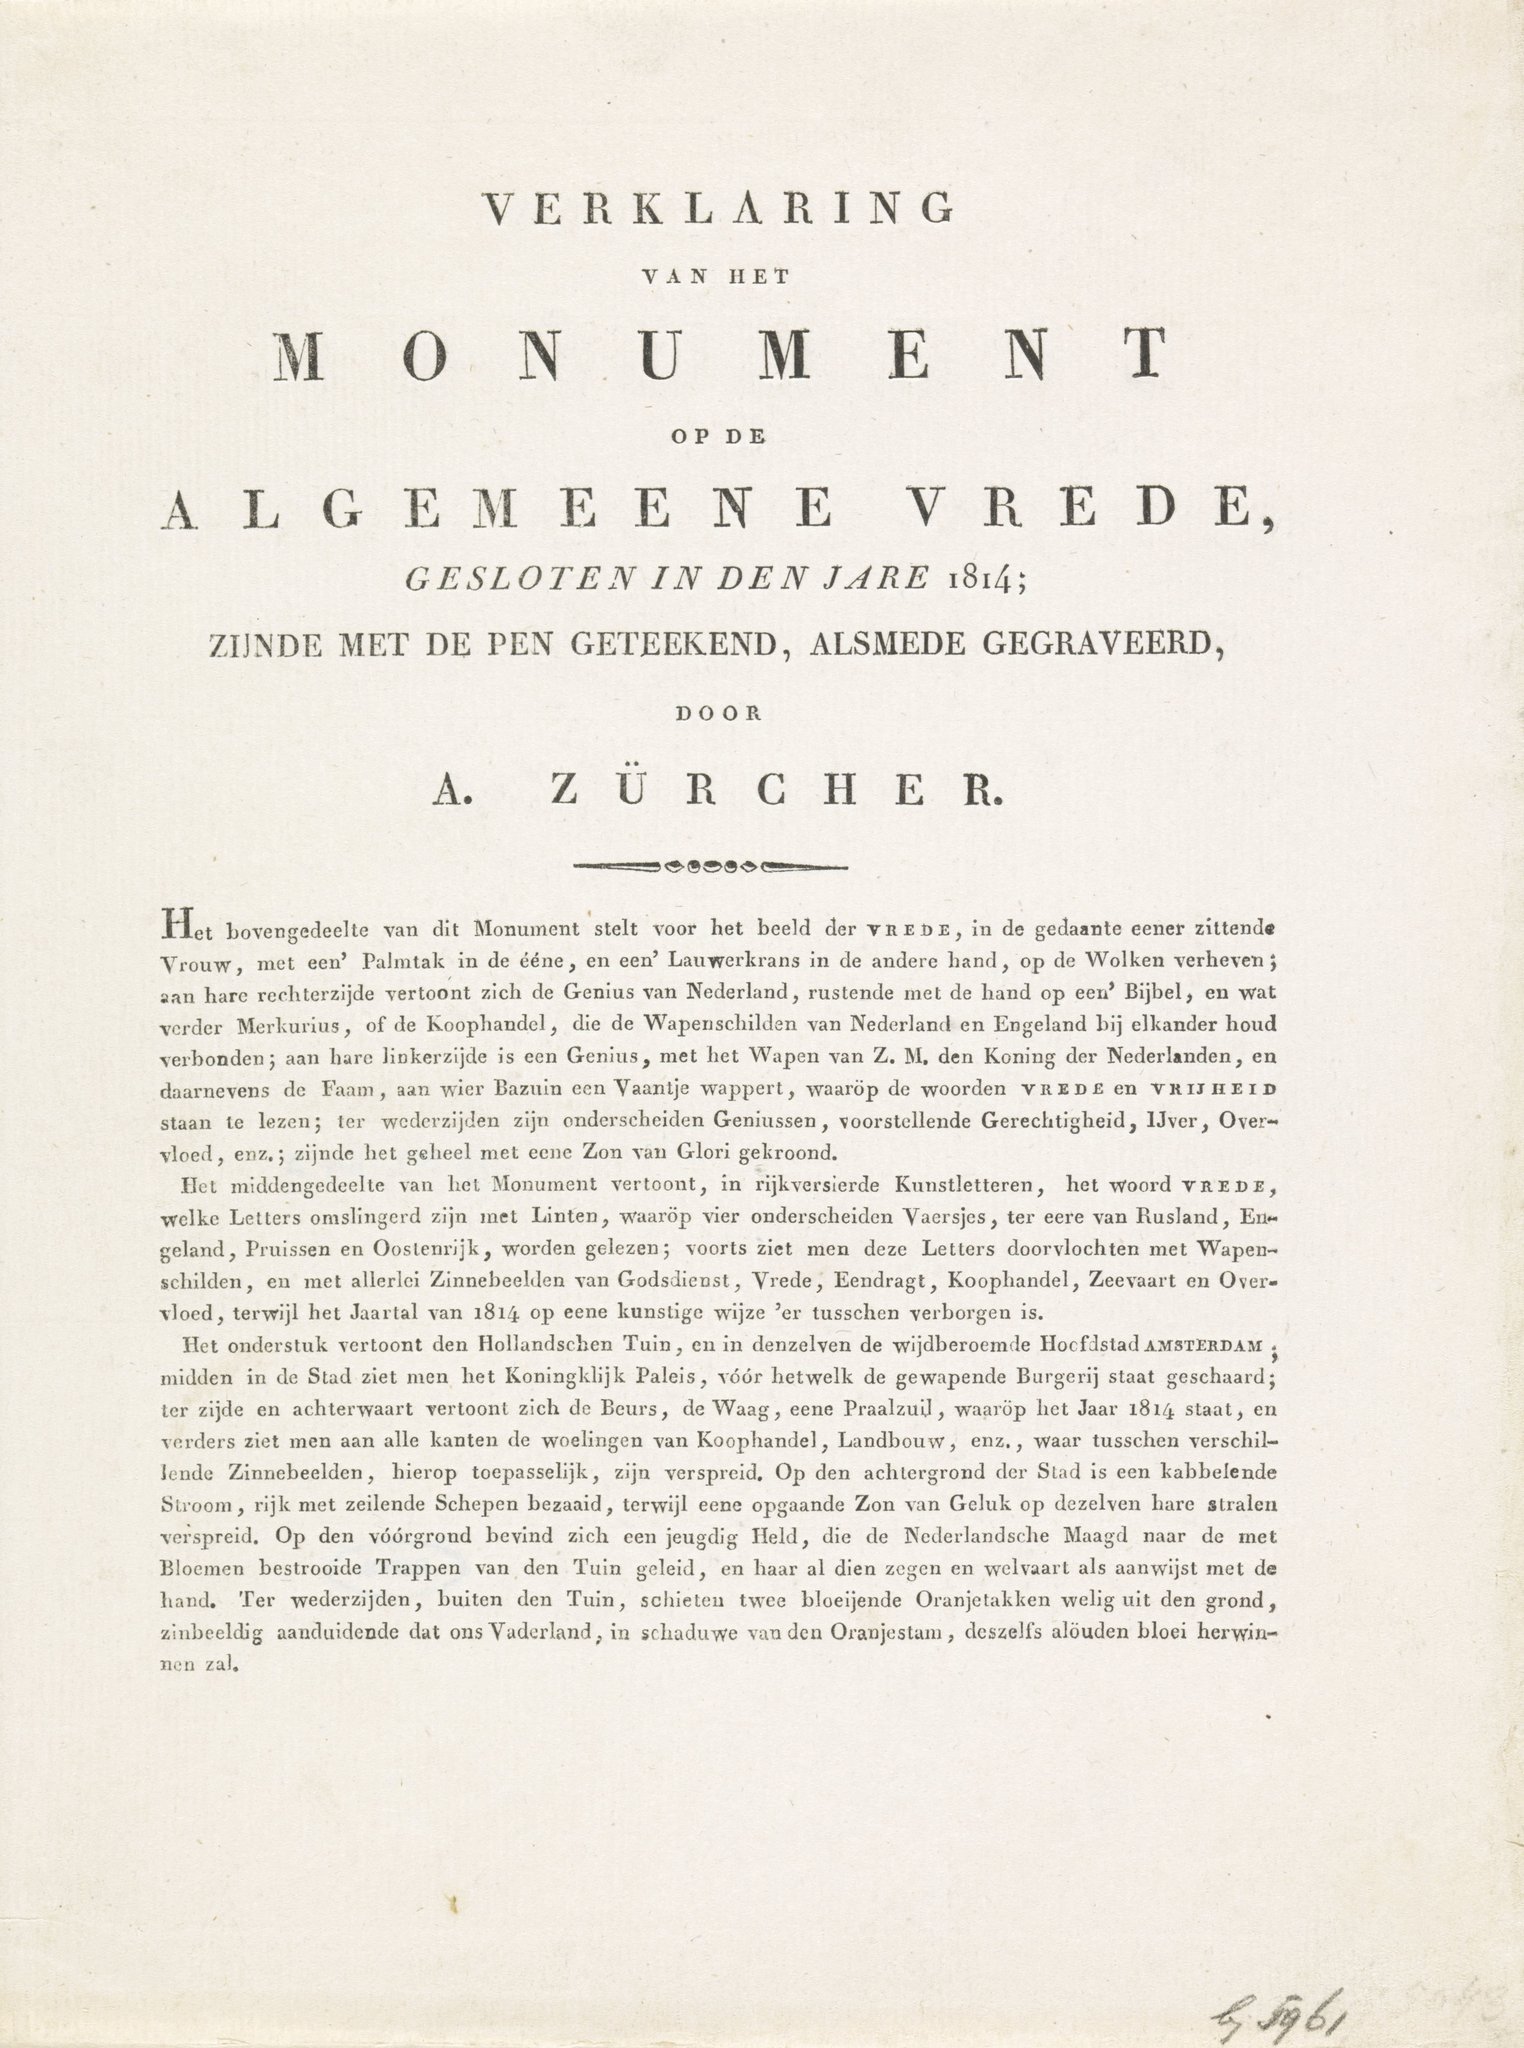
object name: text sheet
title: Verklaring van het Monument op de Algemeene Vrede, gesloten in den jare 1814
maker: Anonymous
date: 1814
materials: paper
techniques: letterpress printing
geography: netherlands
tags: vrede van parijs (1814)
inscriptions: collector's mark: Lugt 2228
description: Tekstblad met een verklaring van de voorstelling van de prent met de allegorie op de eerste Vrede van Parijs, 30 mei 1814.